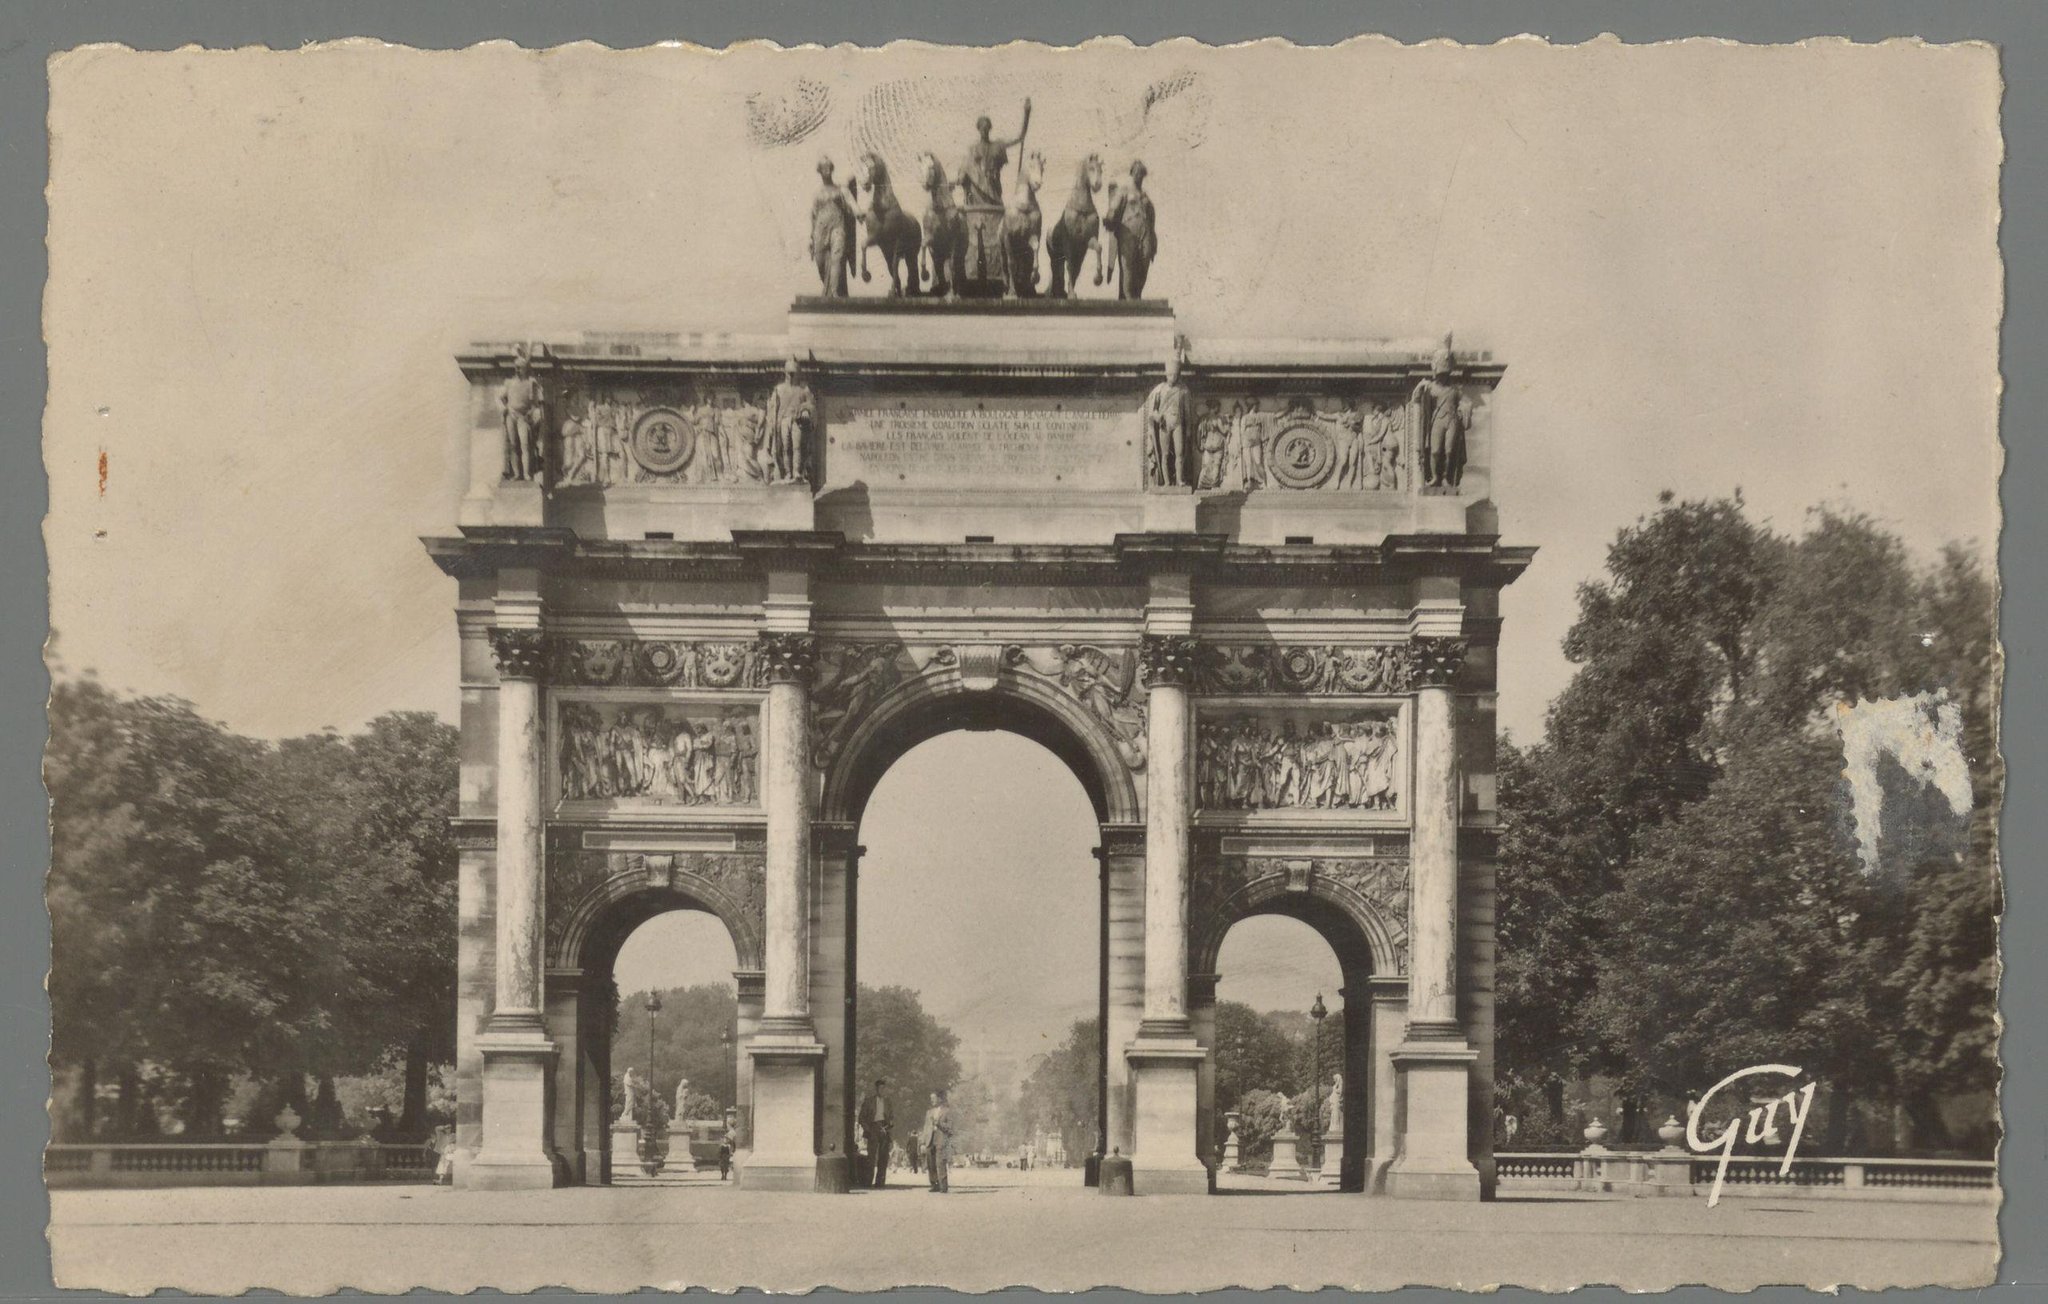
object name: ansichtkaart, prentbriefkaart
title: Arc de Triomphe du Carrousel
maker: andré leconte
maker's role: publisher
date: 1945-1950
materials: photographic support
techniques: photography, writing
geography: paris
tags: avenue, boulevard, promenade, esplanade (+ city(-scape) with figures, staffage), triumphal arch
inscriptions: postage stamp